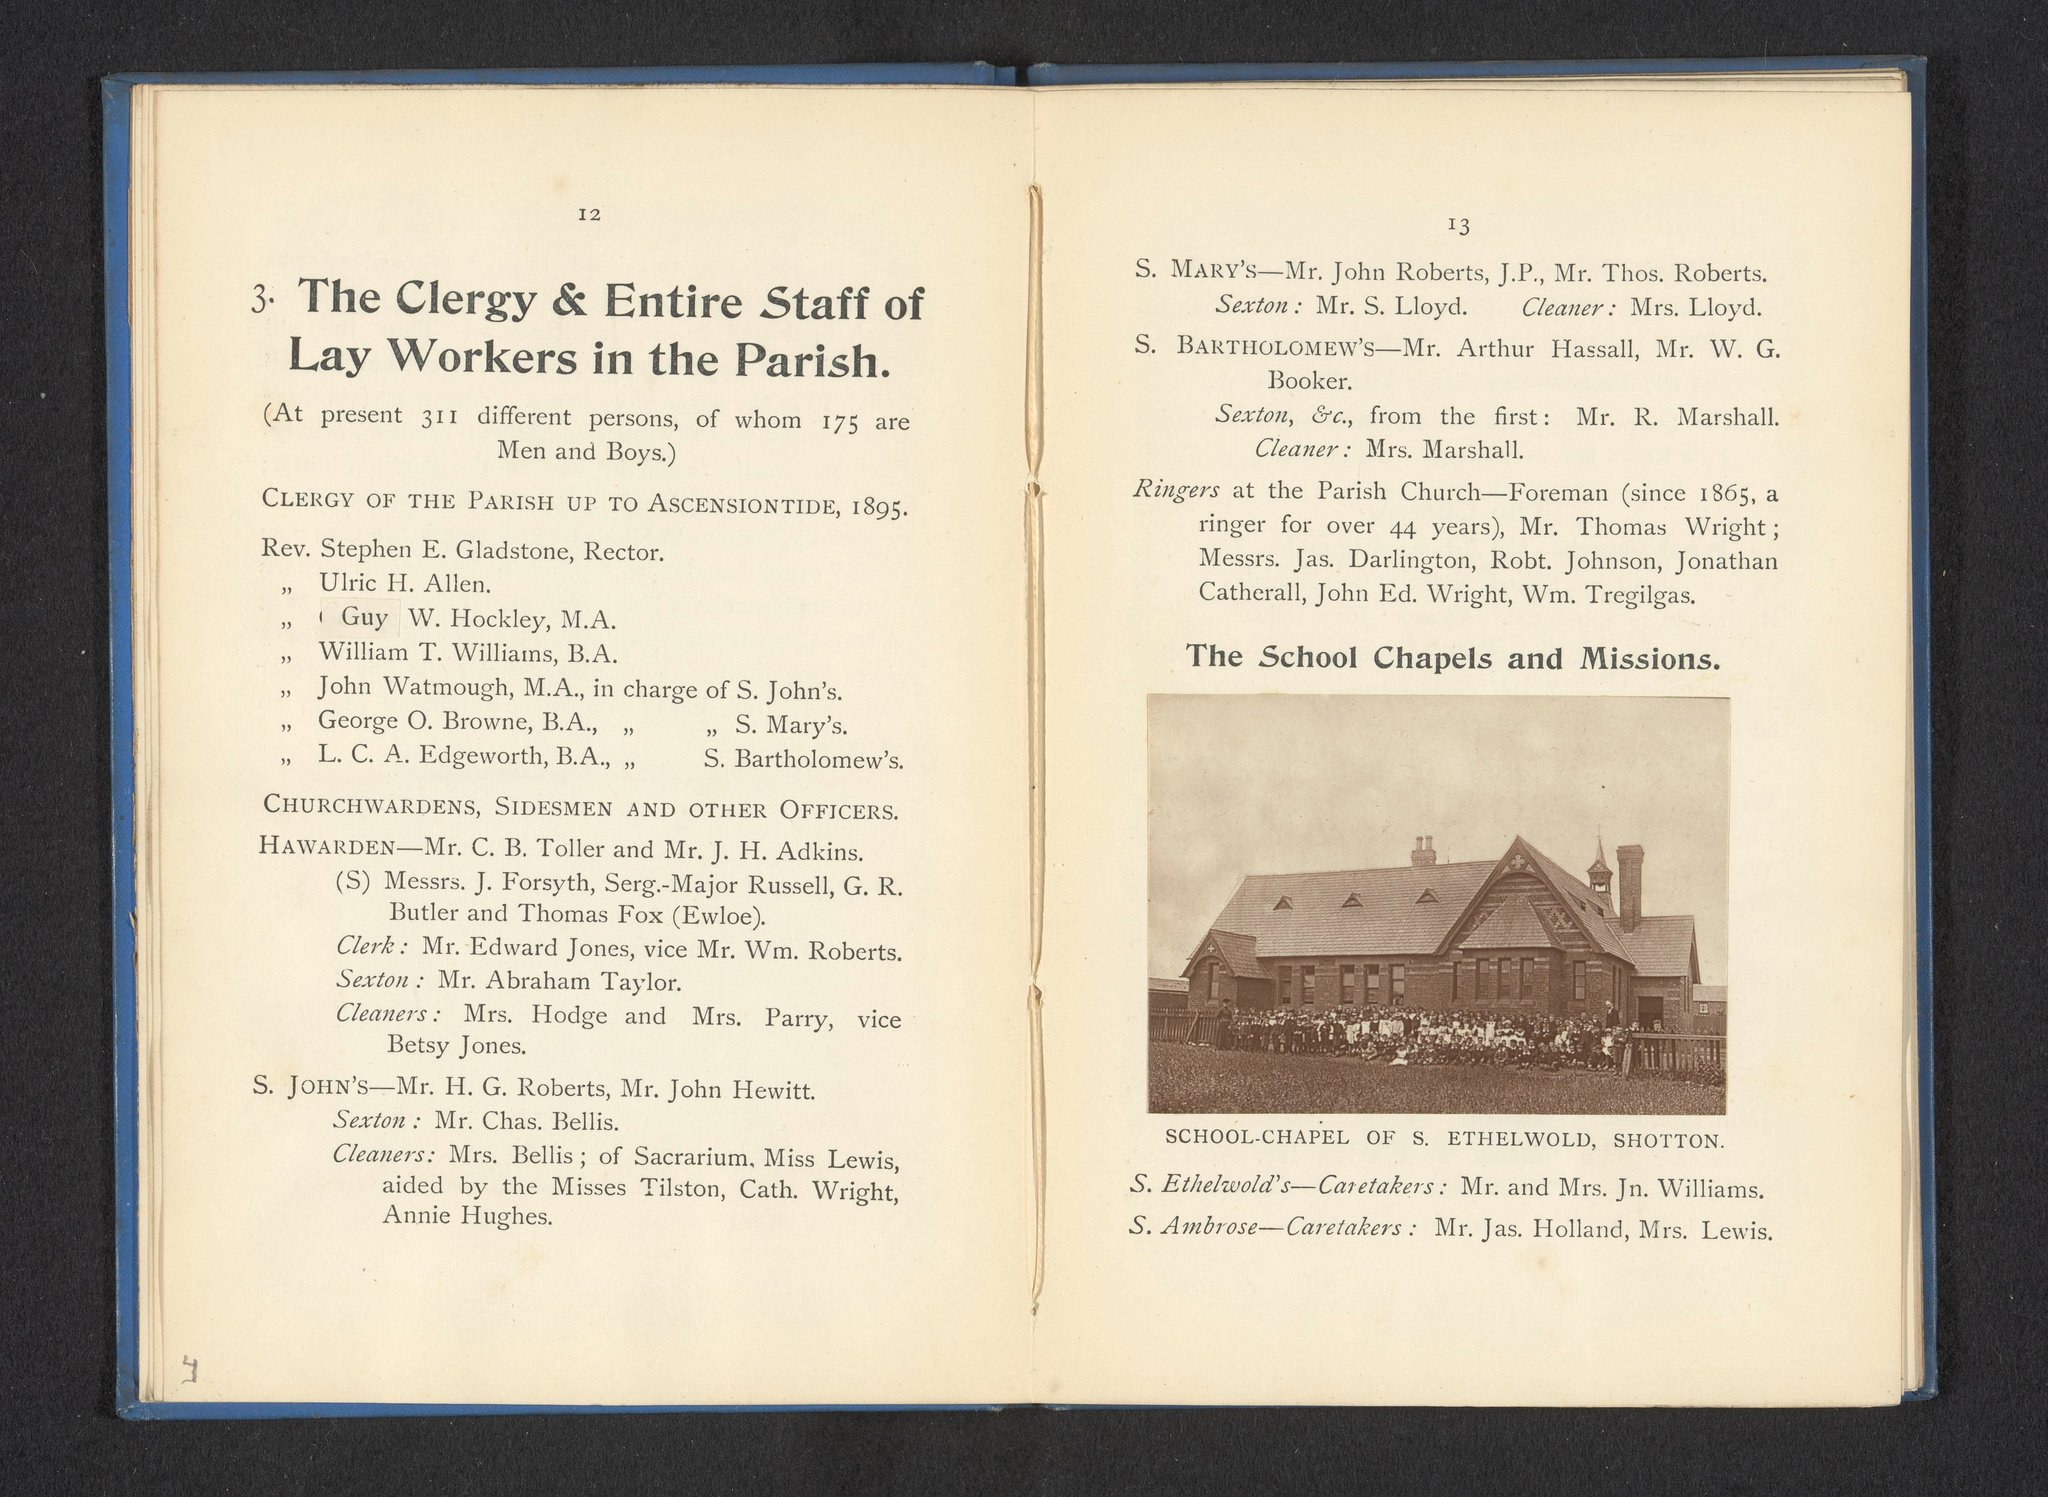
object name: page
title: School-chapel of S. Ethelwold, Shotton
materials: paper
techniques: woodburytype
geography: shotton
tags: parts of church exterior and annexes: chapel, façade (of house or building)